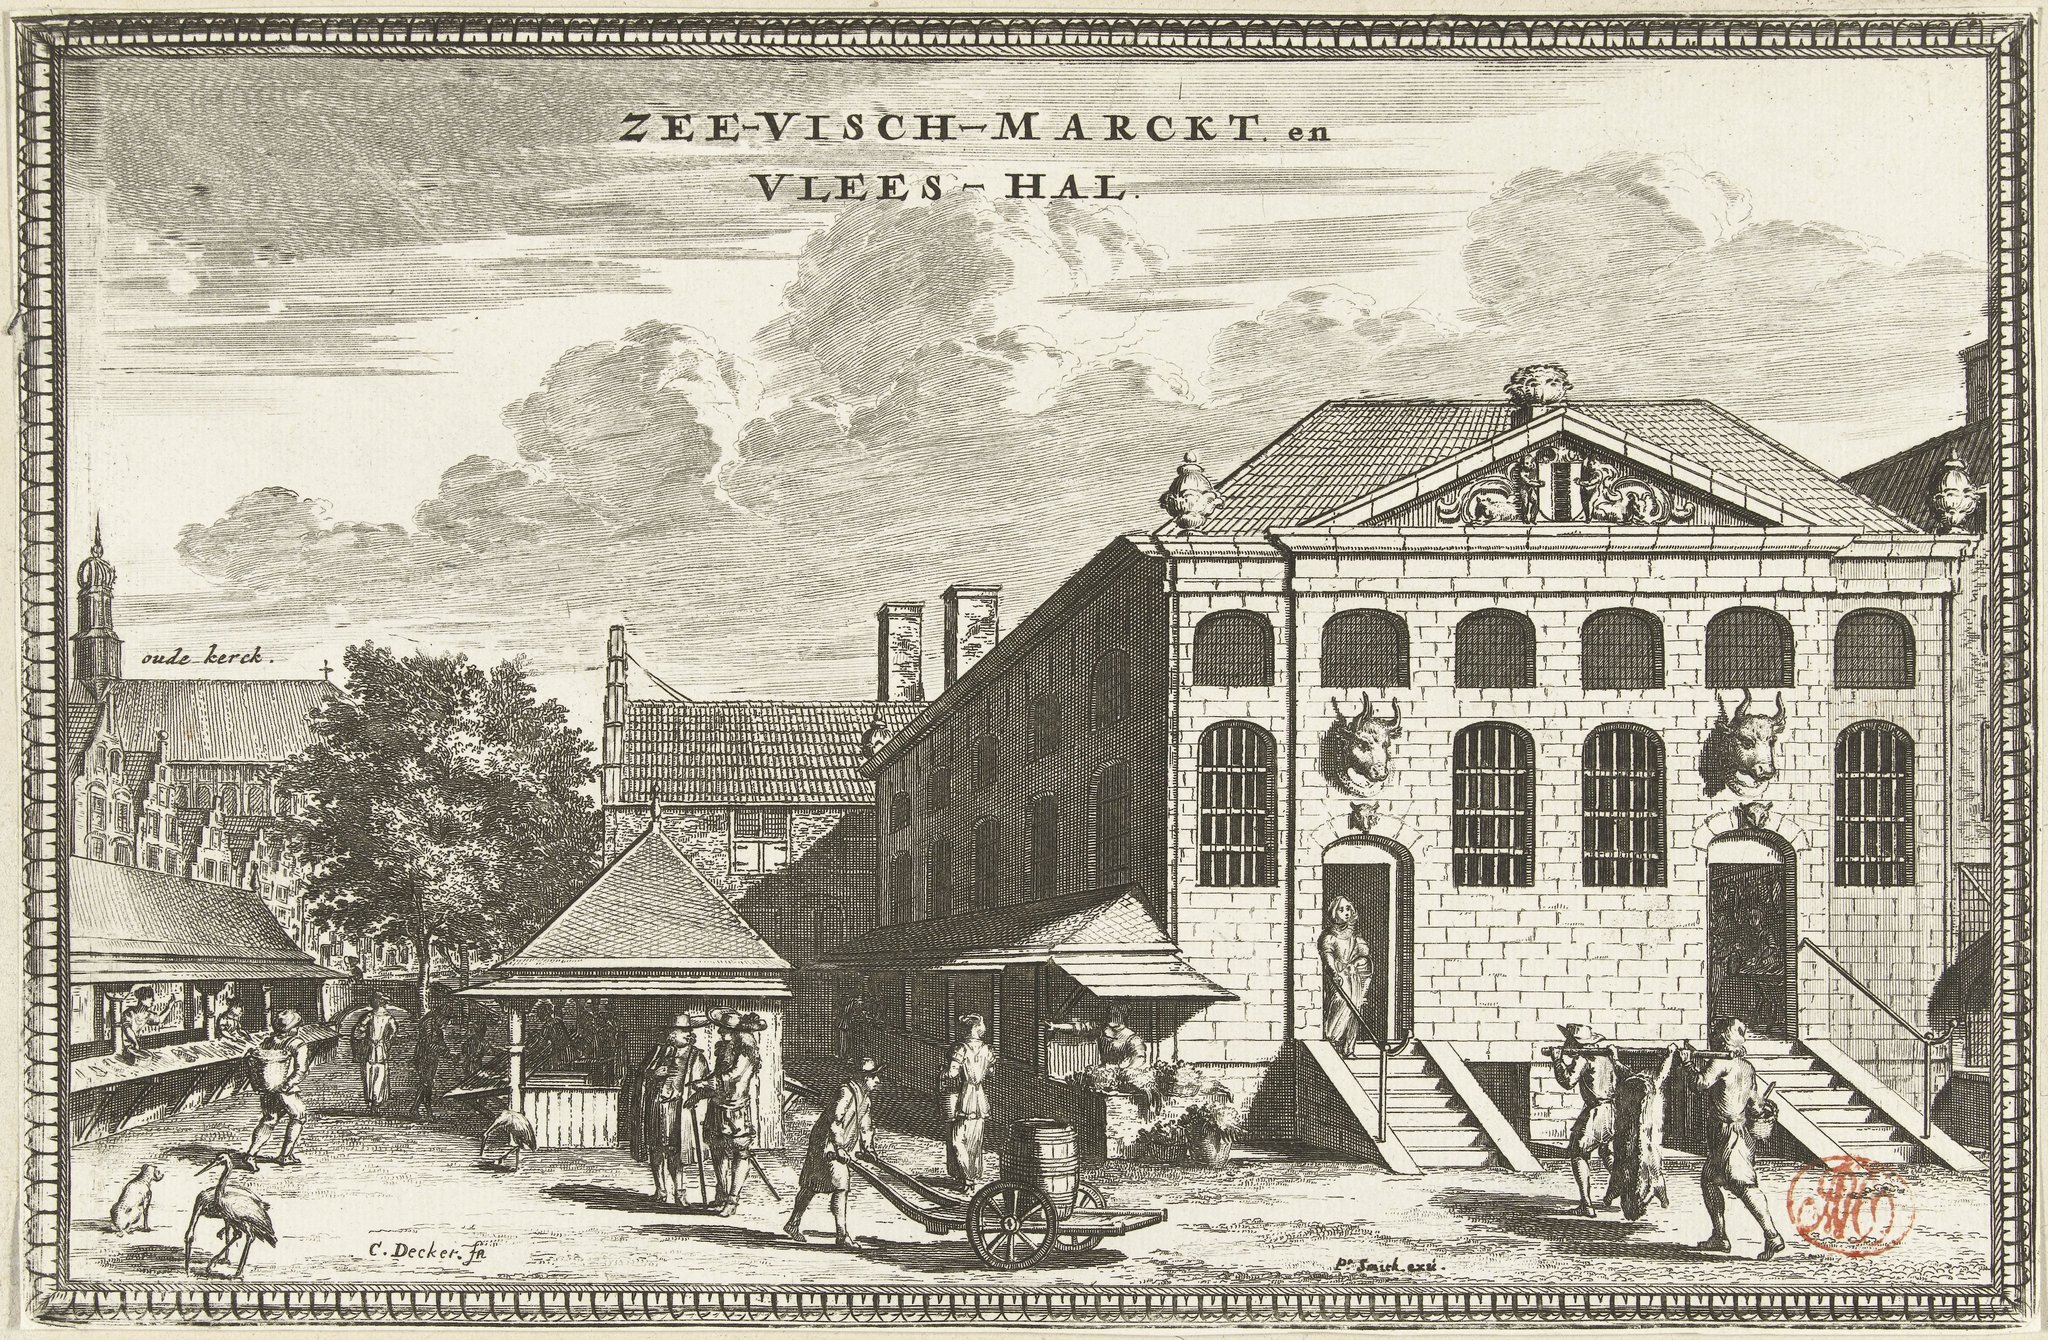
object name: print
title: Zee-visch marckt en Vlees-hal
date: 1678-1703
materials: paper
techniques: etching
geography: amsterdam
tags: shore-birds and wading-birds: stork, market-hall, street (+ city(-scape) with figures, staffage)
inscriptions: collector's mark: Lugt 2228, collector's mark: Lugt 195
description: Deze prent is in 1678 voor het eerst uitgegeven als onderdeel van de rand van de zogenaamde Kaart Figuratief (Caerte figuratyff / Kaerte figuratyf) van Delft, een wandkaart van Delft. Deze kaart bestaat uit een plattegrond van Delft (RP-P-AO-11-8A) met daaromheen een rand. De rand bestaat uit een profiel van Delft (RP-P-AO-11-11), een profiel van Delfshaven met daaronder de wapenschilden van de burgemeesters van de stad (RP-P-AO-13-51-1 en RP-P-AO-13-51-2), 24 kleinere prenten (kaarten, afbeeldingen van gebouwen en graven van bekende personen, o.a. huidige prent, RP-P-AO-11-15, RP-P-AO-11-16, RP-P-AO-11-17, RP-P-AO-11-18, RP-P-AO-11-19, RP-P-AO-11-21, RP-P-AO-11-23, RP-P-AO-11-24, RP-P-AO-11-27, RP-P-AO-11-28, RP-P-AO-11-29, RP-P-AO-11-30, RP-P-AO-11-31, RP-P-AO-11-33C, RP-P-AO-11-34, RP-P-AO-11-35, RP-P-AO-11-35-2, RP-P-AO-13-49, RP-P-AO-13-52, RP-P-AO-13-53, RP-P-AO-13-54-1 en RP-P-1909-6463) en een beschrijving van de stad (RP-P-AO-11-8E). De eerste druk van deze Kaart Figuratief (1678) werd, in opdracht van het Delftse stadsbestuur, verzorgd door Pieter Smith. In 1680 leverde Smith ook vijfhonderd afdrukken van de randprenten die bestemd waren voor Dirk Evertsz. Bleyswijcks 'Beschryvinge der stadt Delft' (1667) en het tweede deel: 'Vervolg van de beschryvinge der stadt Delft' (1680). In het tweede deel zat een bijlage waarin beschreven staat welke prenten waar in het eerste en tweede deel ingebonden dienden te worden. Een deel van de prenten was dus bestemd voor het in 1667 verschenen eerste deel en kon met het verschijnen van het tweede deel in 1680 alsnog worden ingebonden. Hierdoor wordt vaak gedacht dat de prenten uit het eerste deel dateren uit 1667, hetgeen niet klopt. De huidige prent is zodoende ook gebruikt in: Bleyswijck, Dirk Evertsz. Vervolg van de beschryvinge der stadt Delft, met een generael register over beyde stucken voorsien. Delft: Arnold Bon, 1680, p. 593. Pieter Mortier (I) verzorgde in 1703, tevens in opdracht van het stadsbestuur, een tweede uitgave van de Kaart Figuratief. Voor deze druk bracht graveur Thomas van der Wilt enkele aanpassingen aan op de platen van de plattegrond. De randplaten lijken, op de plaat met de wapens van de burgemeesters na, ongewijzigd te zijn gebleven. De plattegrond is in 1752, waarschijnlijk zonder de randprenten, opnieuw uitgegeven. Een deel van de randprenten, waaronder de huidige prent, is in 1729 opnieuw gebruikt in: Beschryving der stadt Delft, behelzende een zeer naaukeurige en uitvoerige verhandeling van deszelfs eerste oorsprong (…). Delft: Reinier Boitet, 1729. Op twee na (die van de Nieuwe en Oude Kerk) paste Boitet de platen aan, waardoor van deze prenten een tweede staat ontstond. Of de huidige prent is gebruikt als onderdeel van de rand van de Kaart Figuratief uit 1678 of 1703, of is gebruikt in 'Vervolg van de beschryvinge der stadt Delft' (1680), is niet na te gaan.